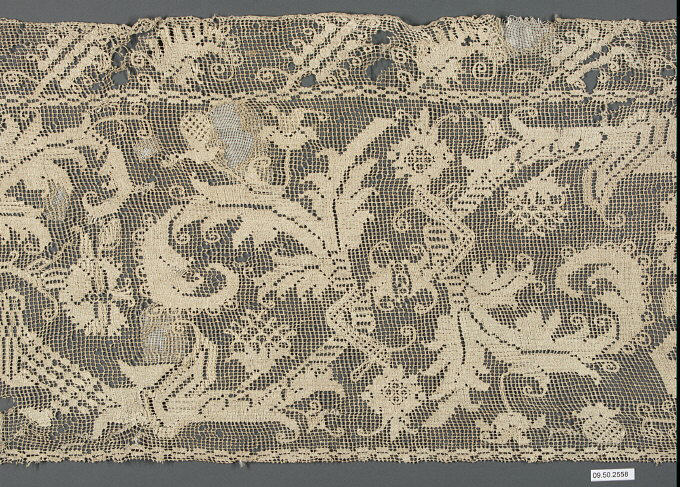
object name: band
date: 1601-1700